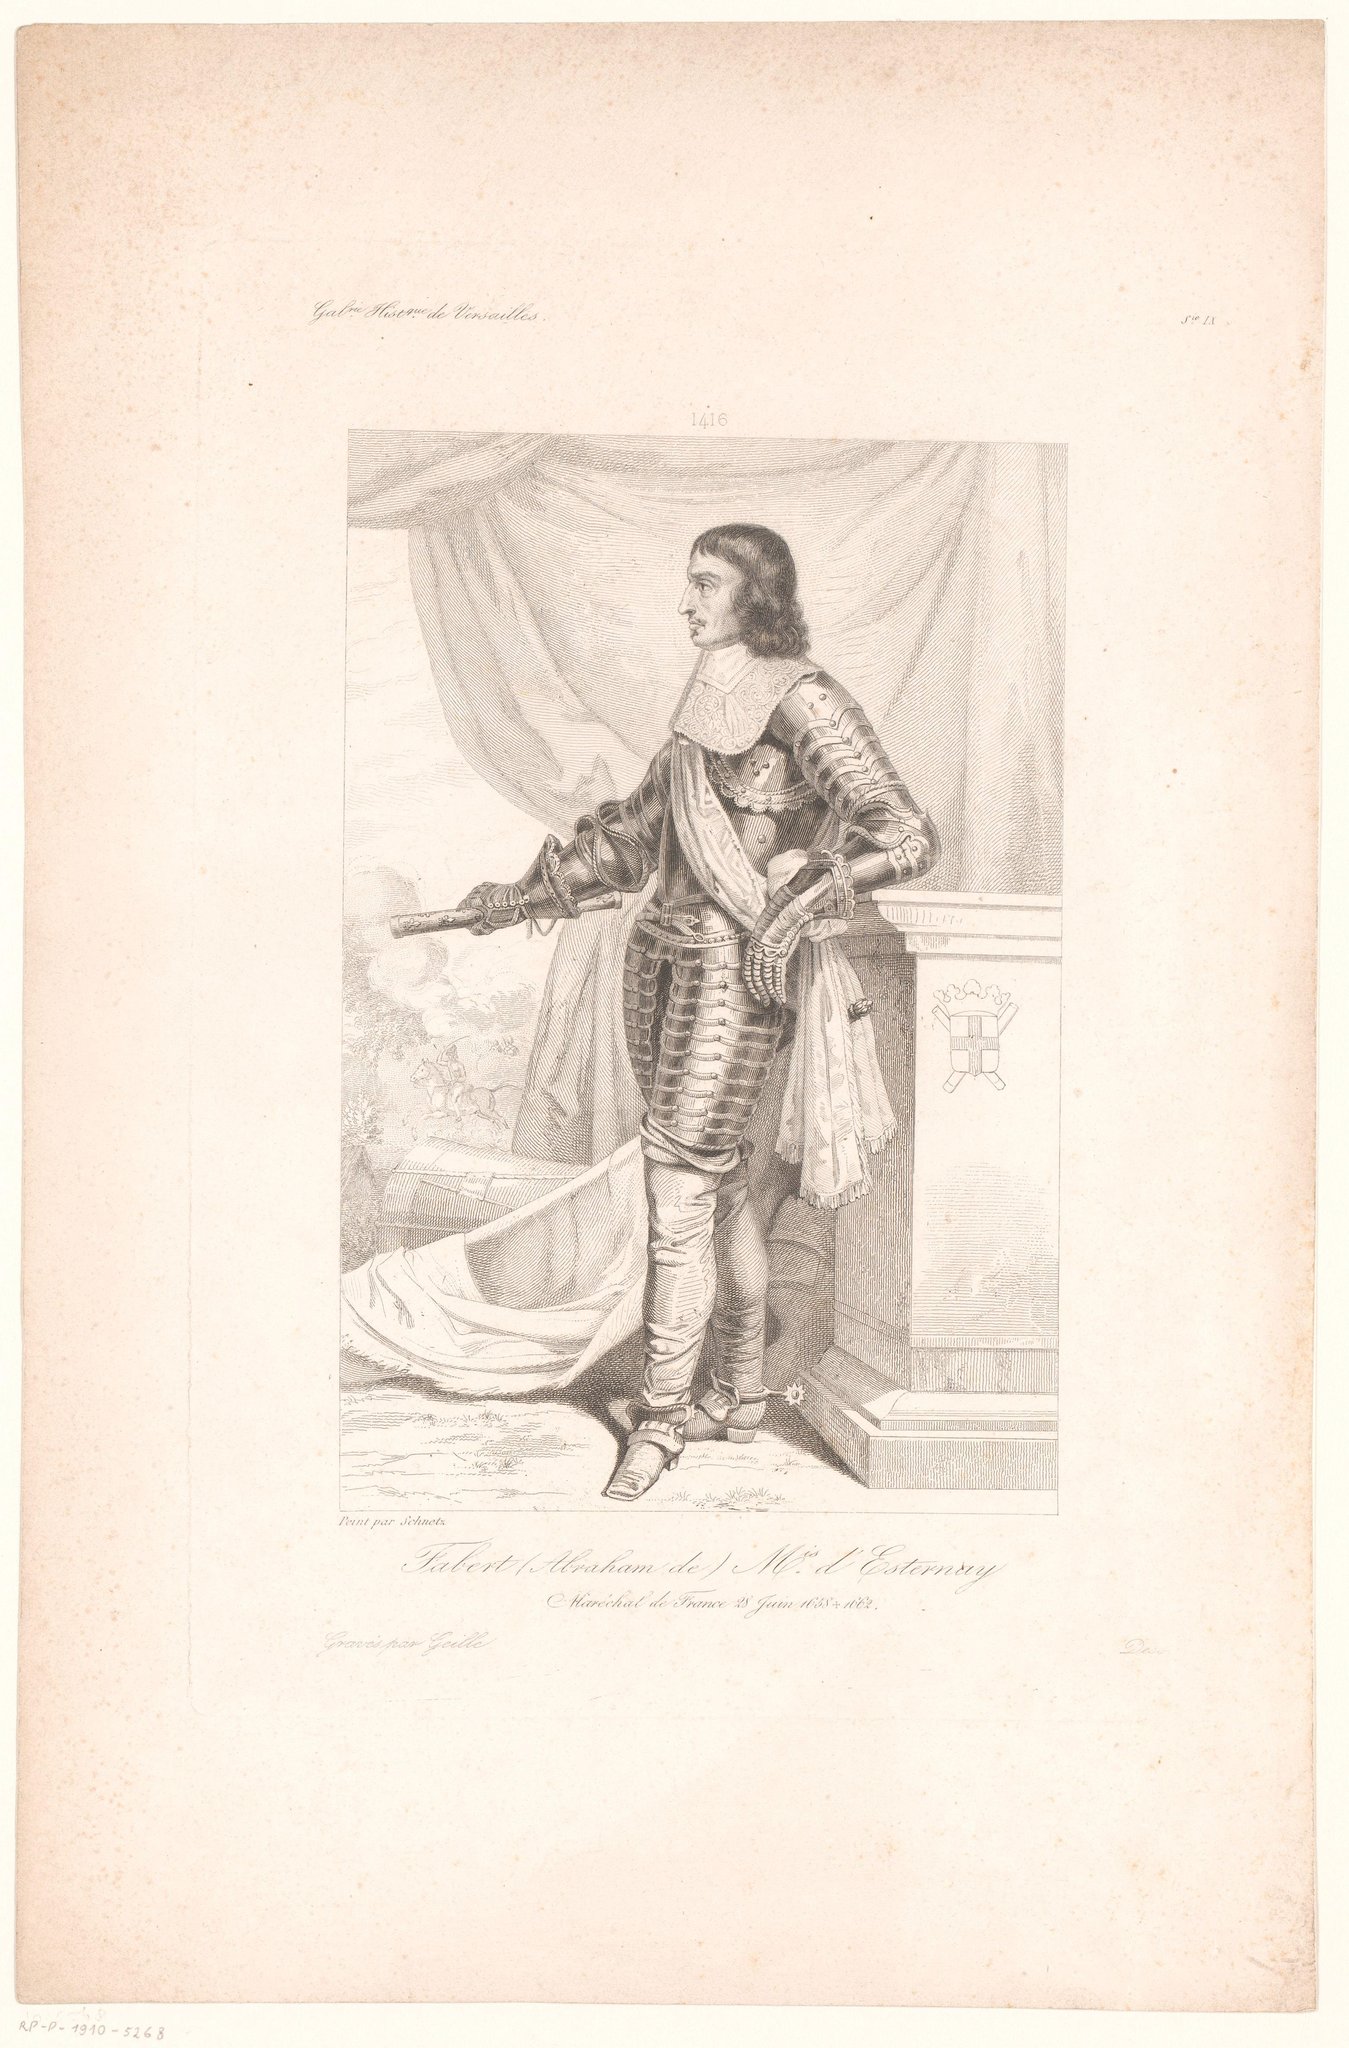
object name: book illustration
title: Portret van Abraham de Fabert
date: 1838-1841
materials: paper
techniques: engraving, etching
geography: paris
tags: armour, historical persons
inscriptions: collector's mark: Lugt 2228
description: Prent uit: Galeries historiques de Versailles. Parijs: Charles Gavard, 1838-1841.